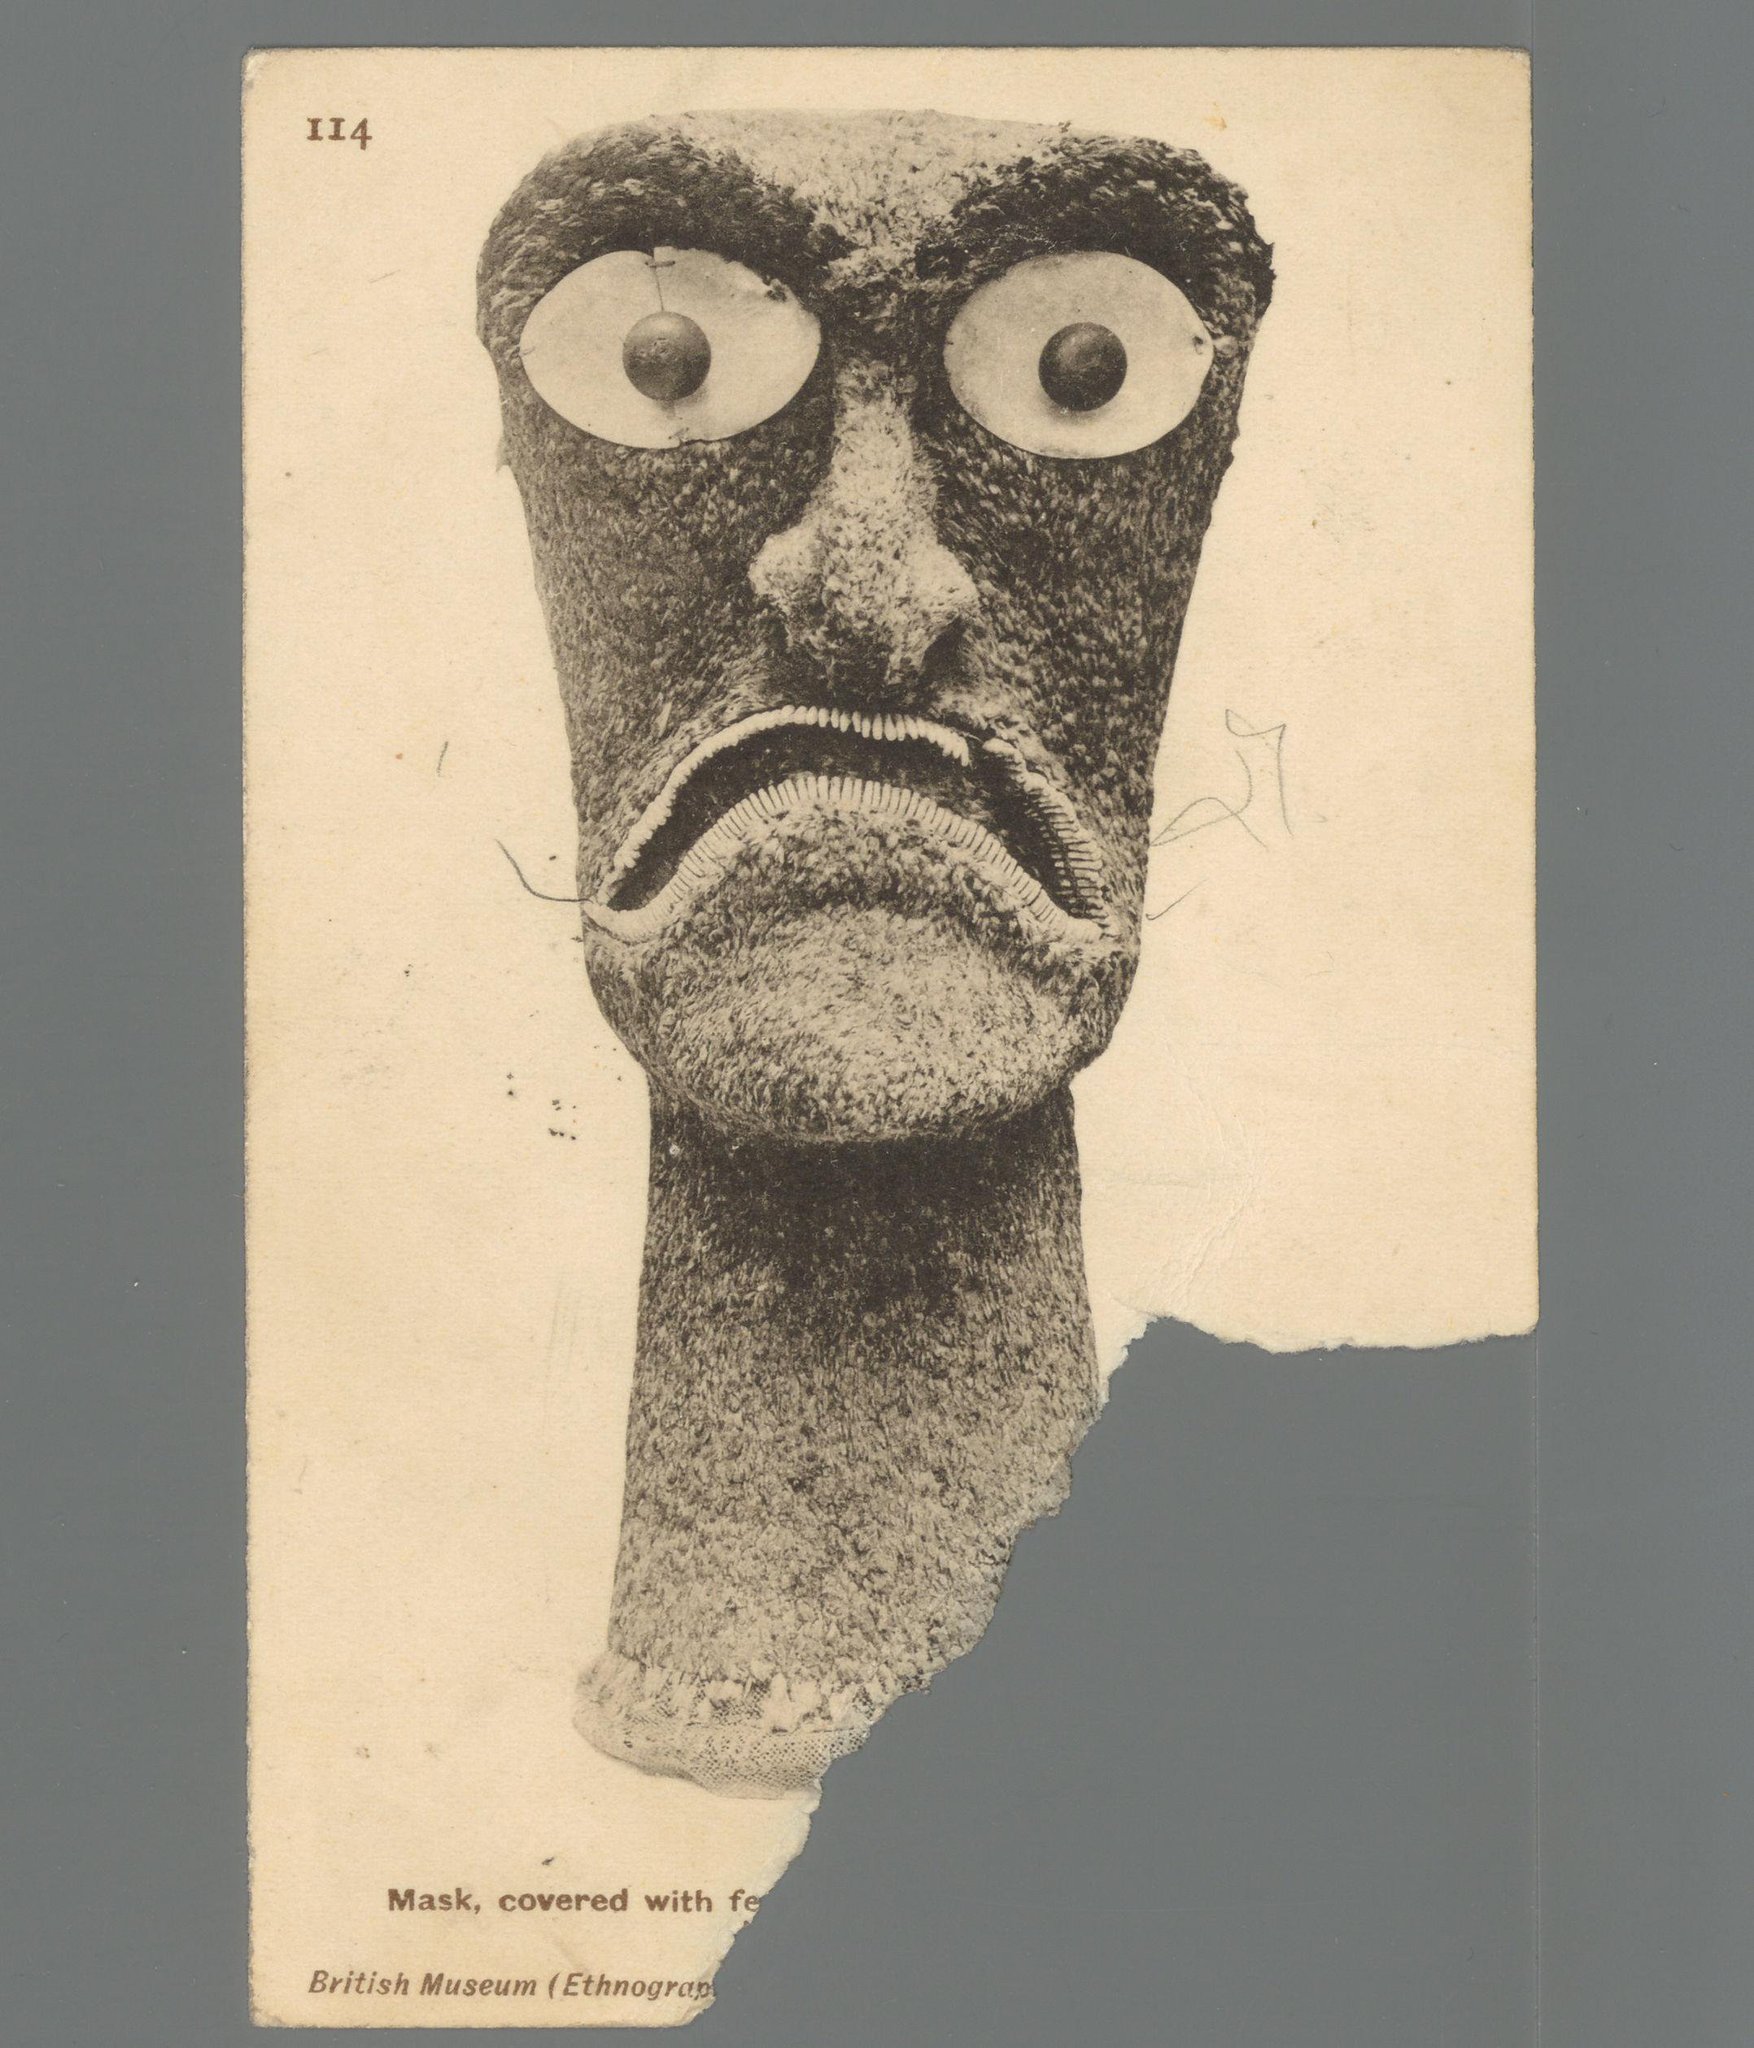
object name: ansichtkaart, prentbriefkaart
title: Mask, covered with fe[...]. British Museum (Ethnograp[...]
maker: Anonymous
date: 1902-1926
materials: cardboard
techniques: photograph, writing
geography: london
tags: mask, permanent exhibition, museum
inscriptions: postage stamp